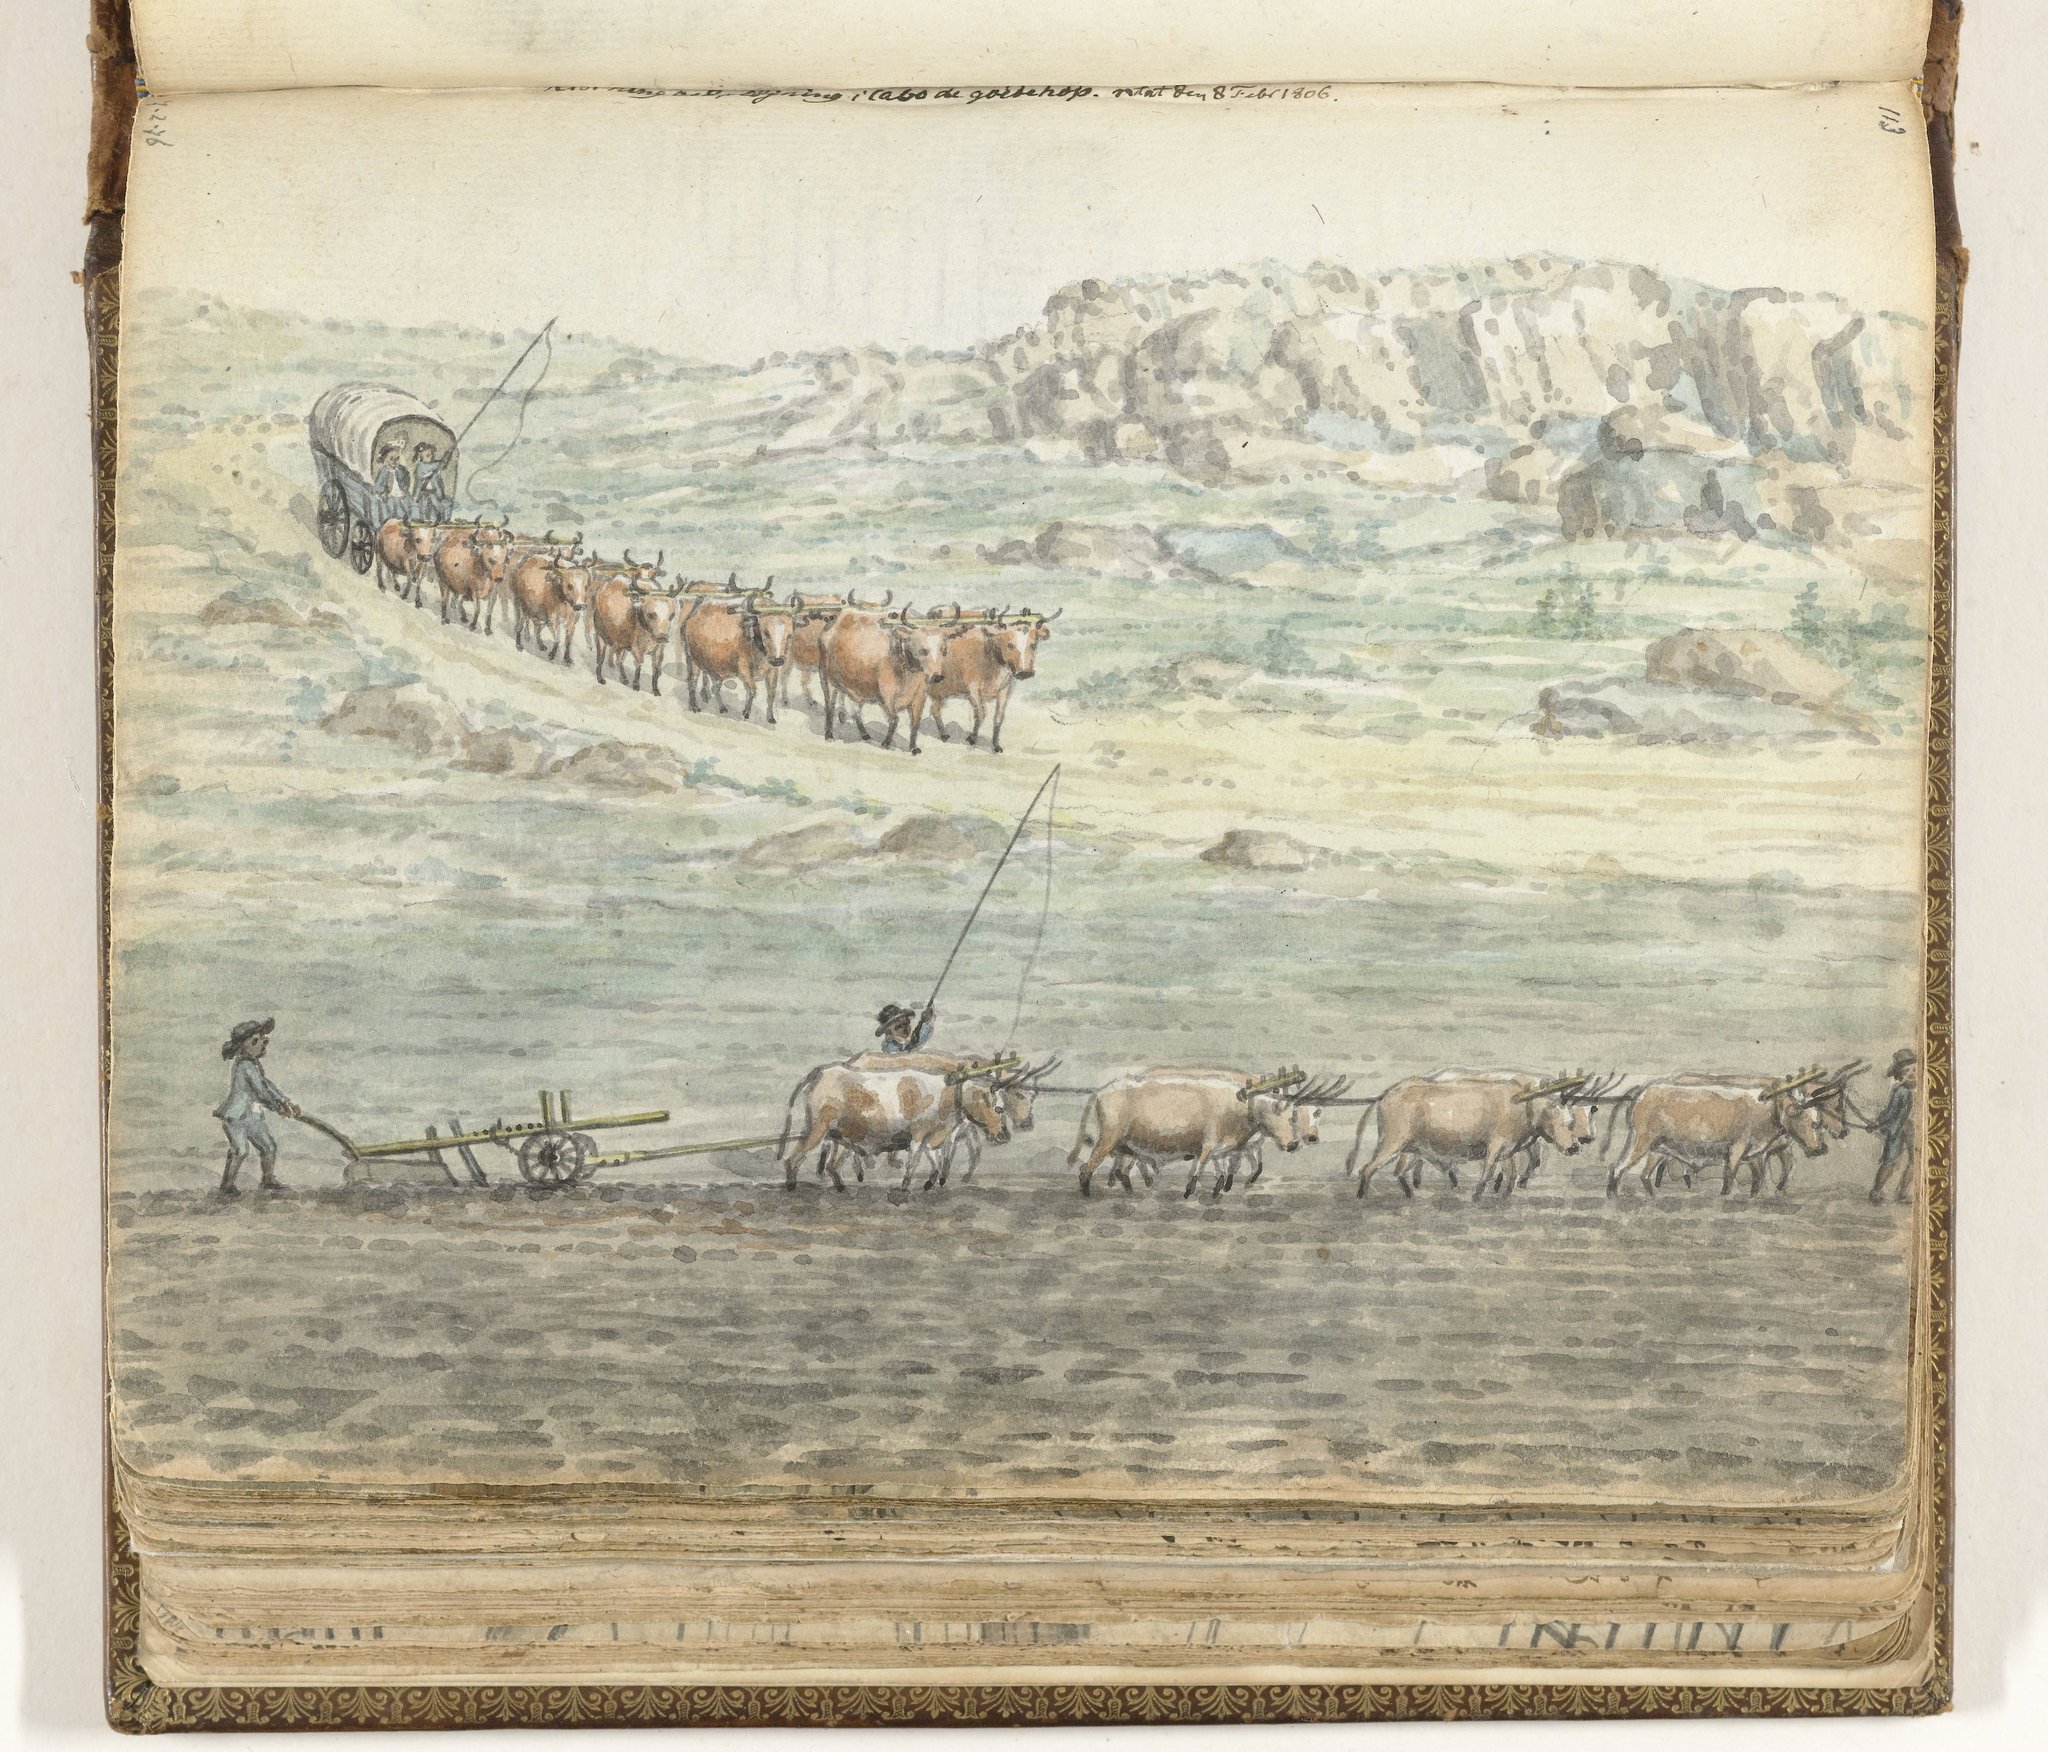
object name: drawing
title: Ossenspan voor huifwagen en voor ploeg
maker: jan brandes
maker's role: draughtsman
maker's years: 1743-1808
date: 1806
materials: paper, pencil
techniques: brush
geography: skälsebo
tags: covered wagon, hooded wagon, agricultural implements: plough, ox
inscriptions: inscription: ‘kiörning och plöjning i cabo de goede hop, ritat den 8 Febr 1806’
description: Kleurtekening van een wagen met 12 ossen, en een ploeg achter 8 ossen in rotsachtig Zuidafrikaans landschap bij de plaats van Lochner. Met opschrift. Onderdeel uit het schetsboek van Jan Brandes, dl. 2 (1808), p. 113.